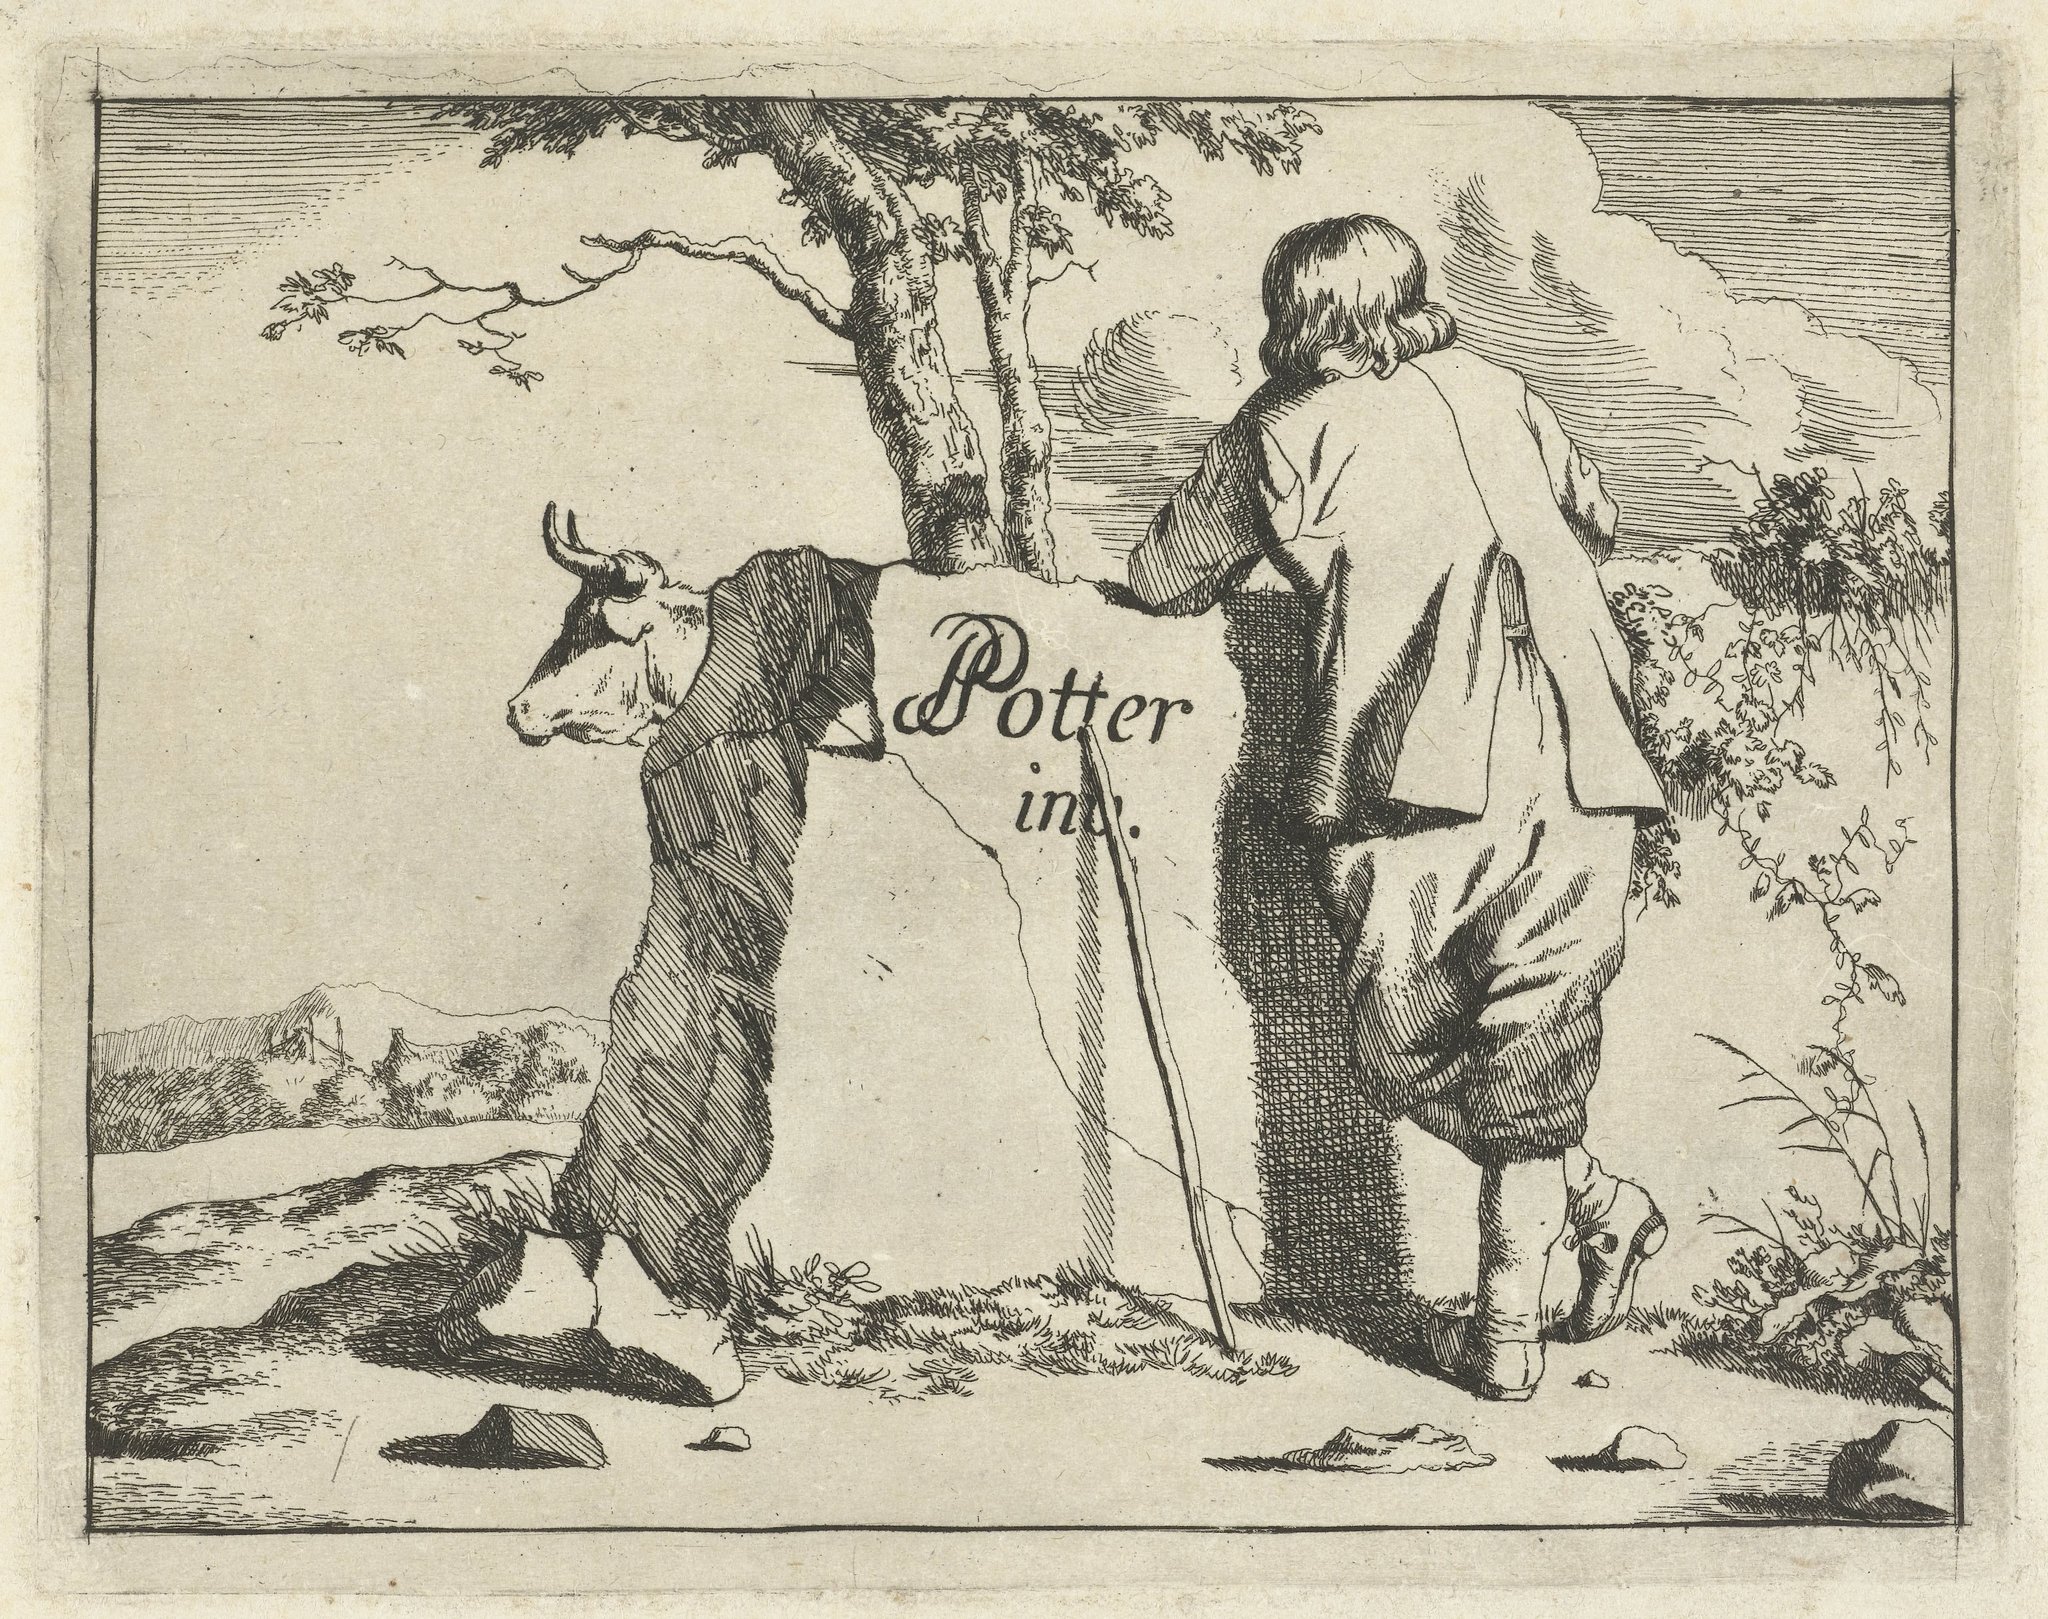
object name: print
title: Koeien en stieren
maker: marcus de bye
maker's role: print maker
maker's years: 1639-1688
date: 1657-1677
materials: paper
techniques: etching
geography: the hague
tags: cow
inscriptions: collector's mark: Lugt 240